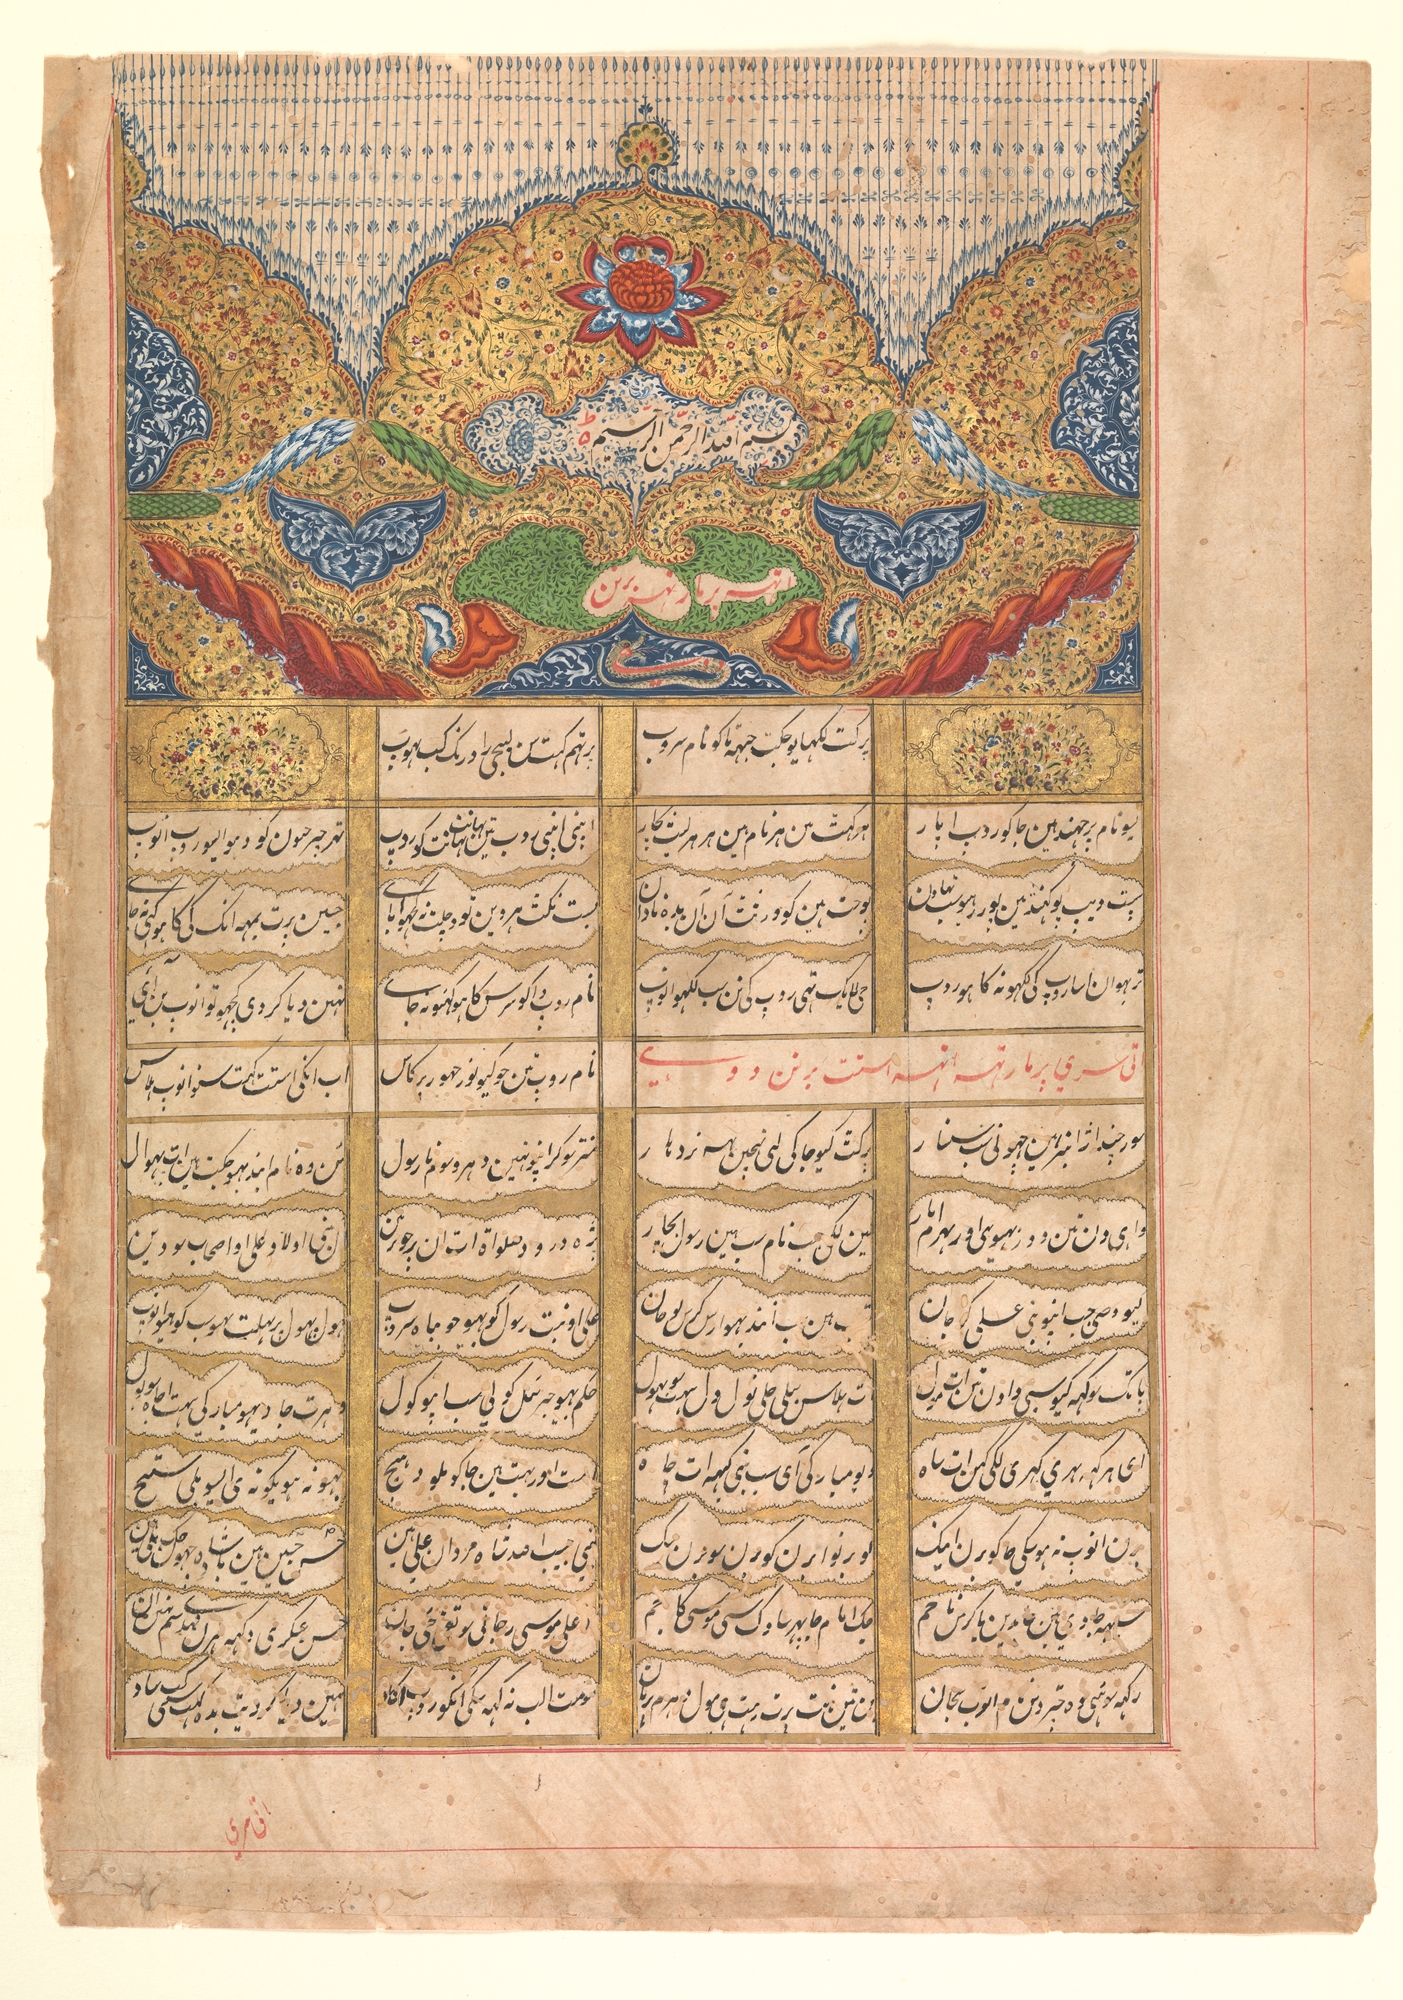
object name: folio from an illustrated manuscript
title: Page of Calligraphy with Unwan from a manuscript of the Raga Darshan of Anup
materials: gold, paper, watercolor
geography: india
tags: calligraphy